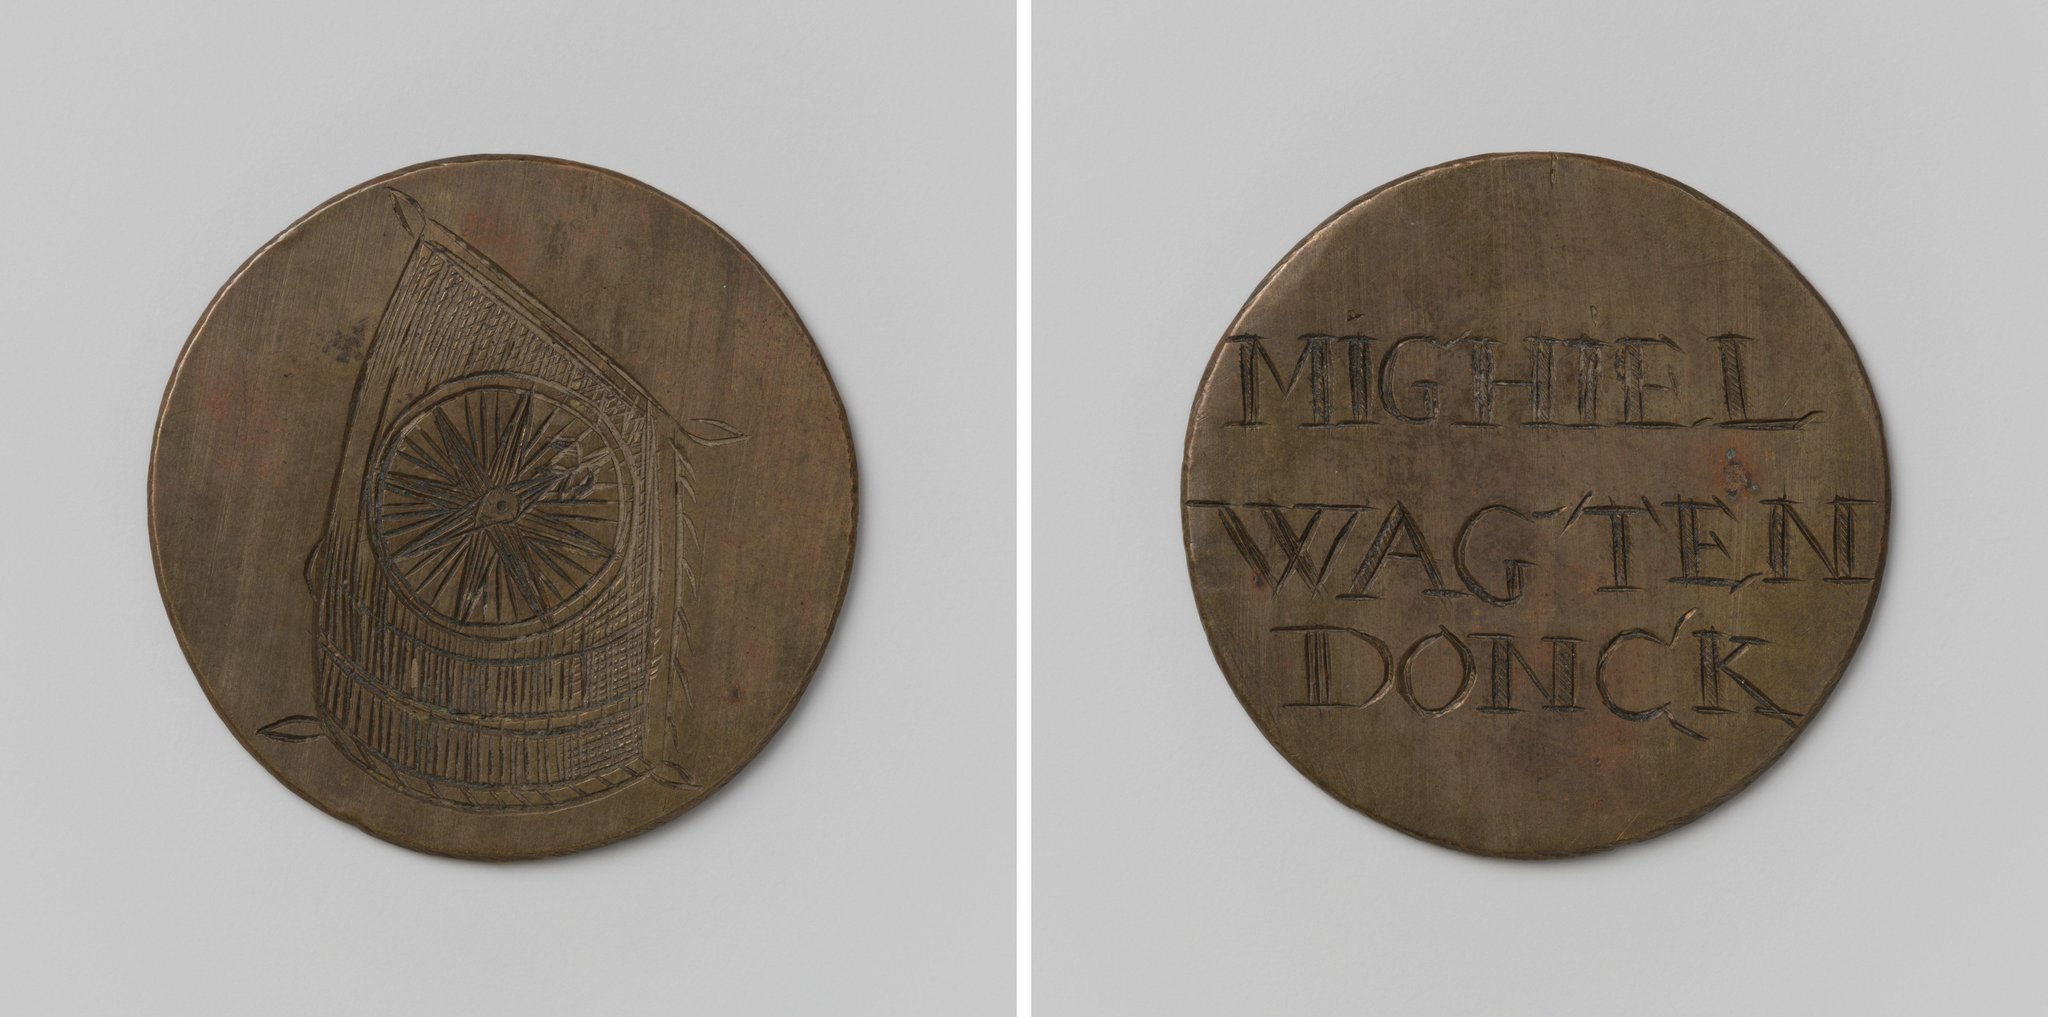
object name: medal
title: Kompas- en zeilmakersgilde van Amsterdam, gildepenning van Mighiel Wagtendonk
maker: Anonymous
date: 1742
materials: brass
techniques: engraving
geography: amsterdam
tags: amsterdam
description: Messing penning, v.z:zeil met daarop afbeelding van kompas. Keerzijde: opschrift.